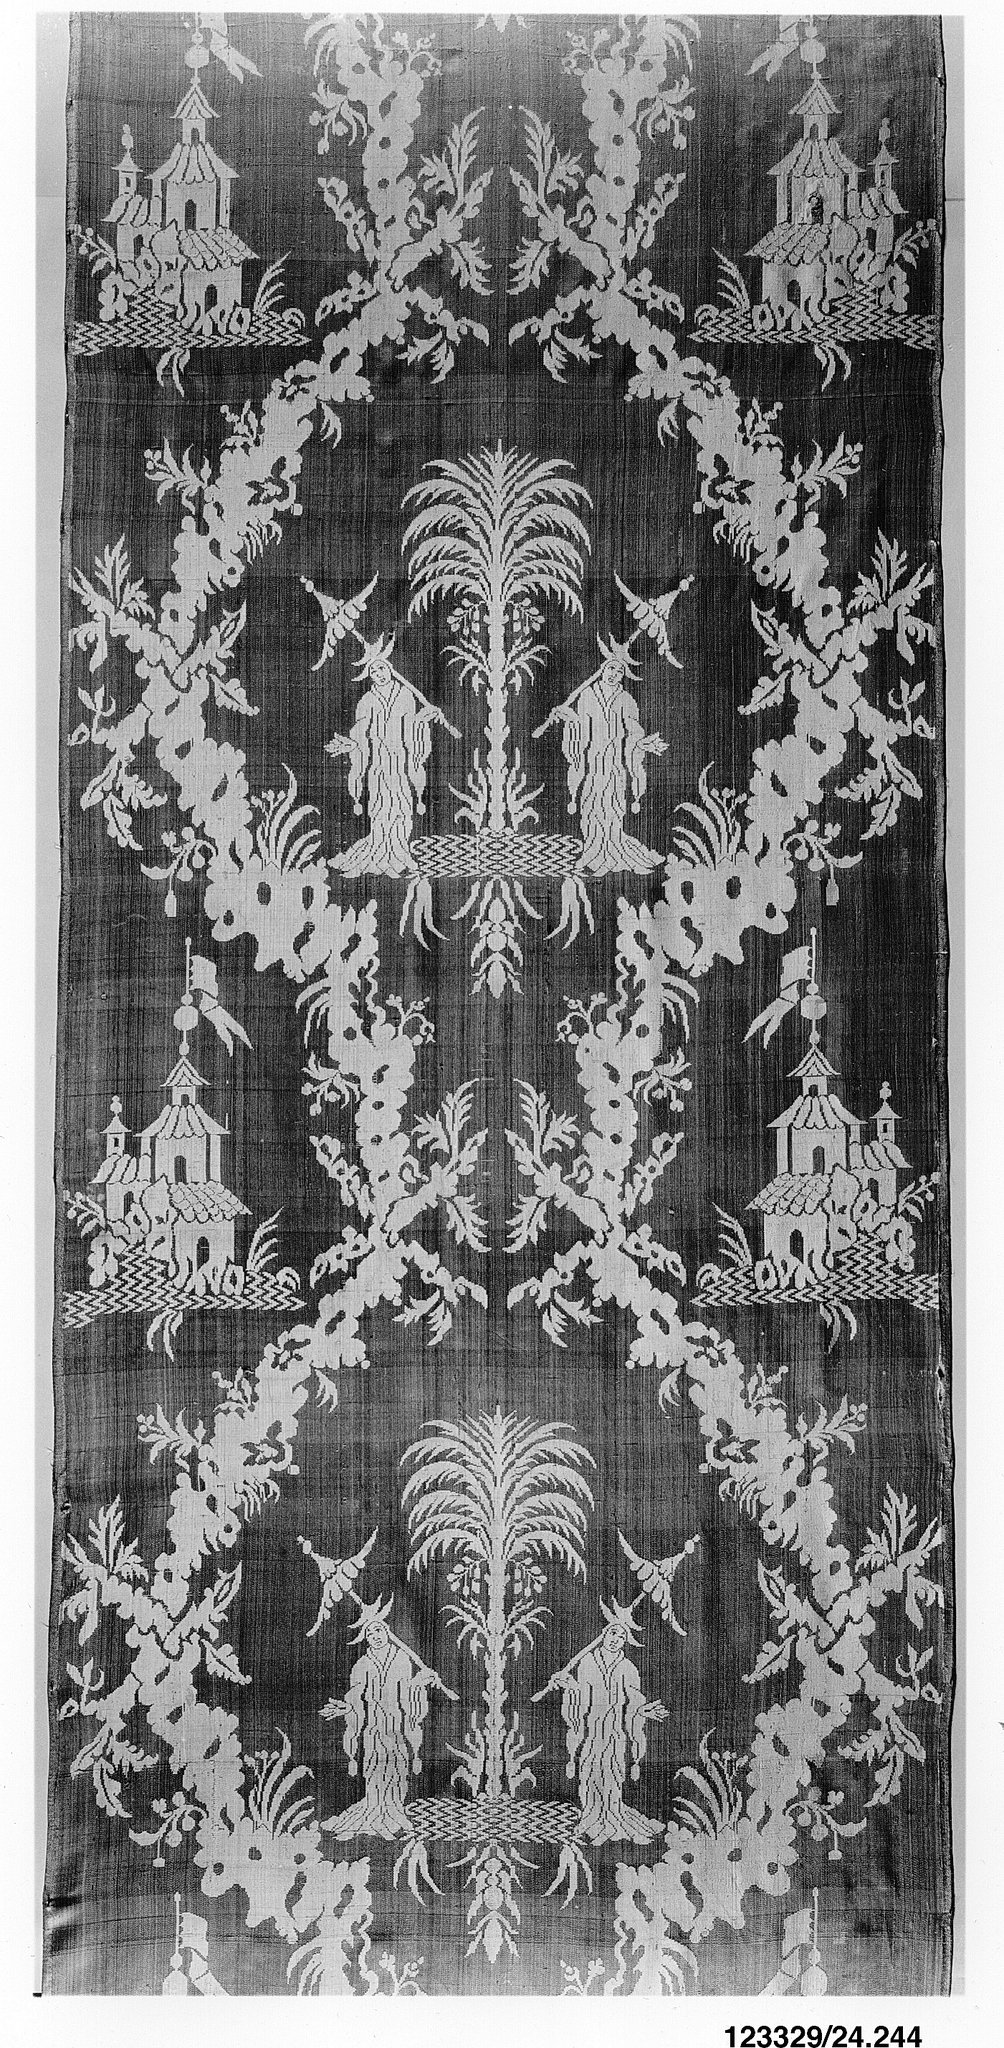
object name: piece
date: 1765-1775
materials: silk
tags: human figures